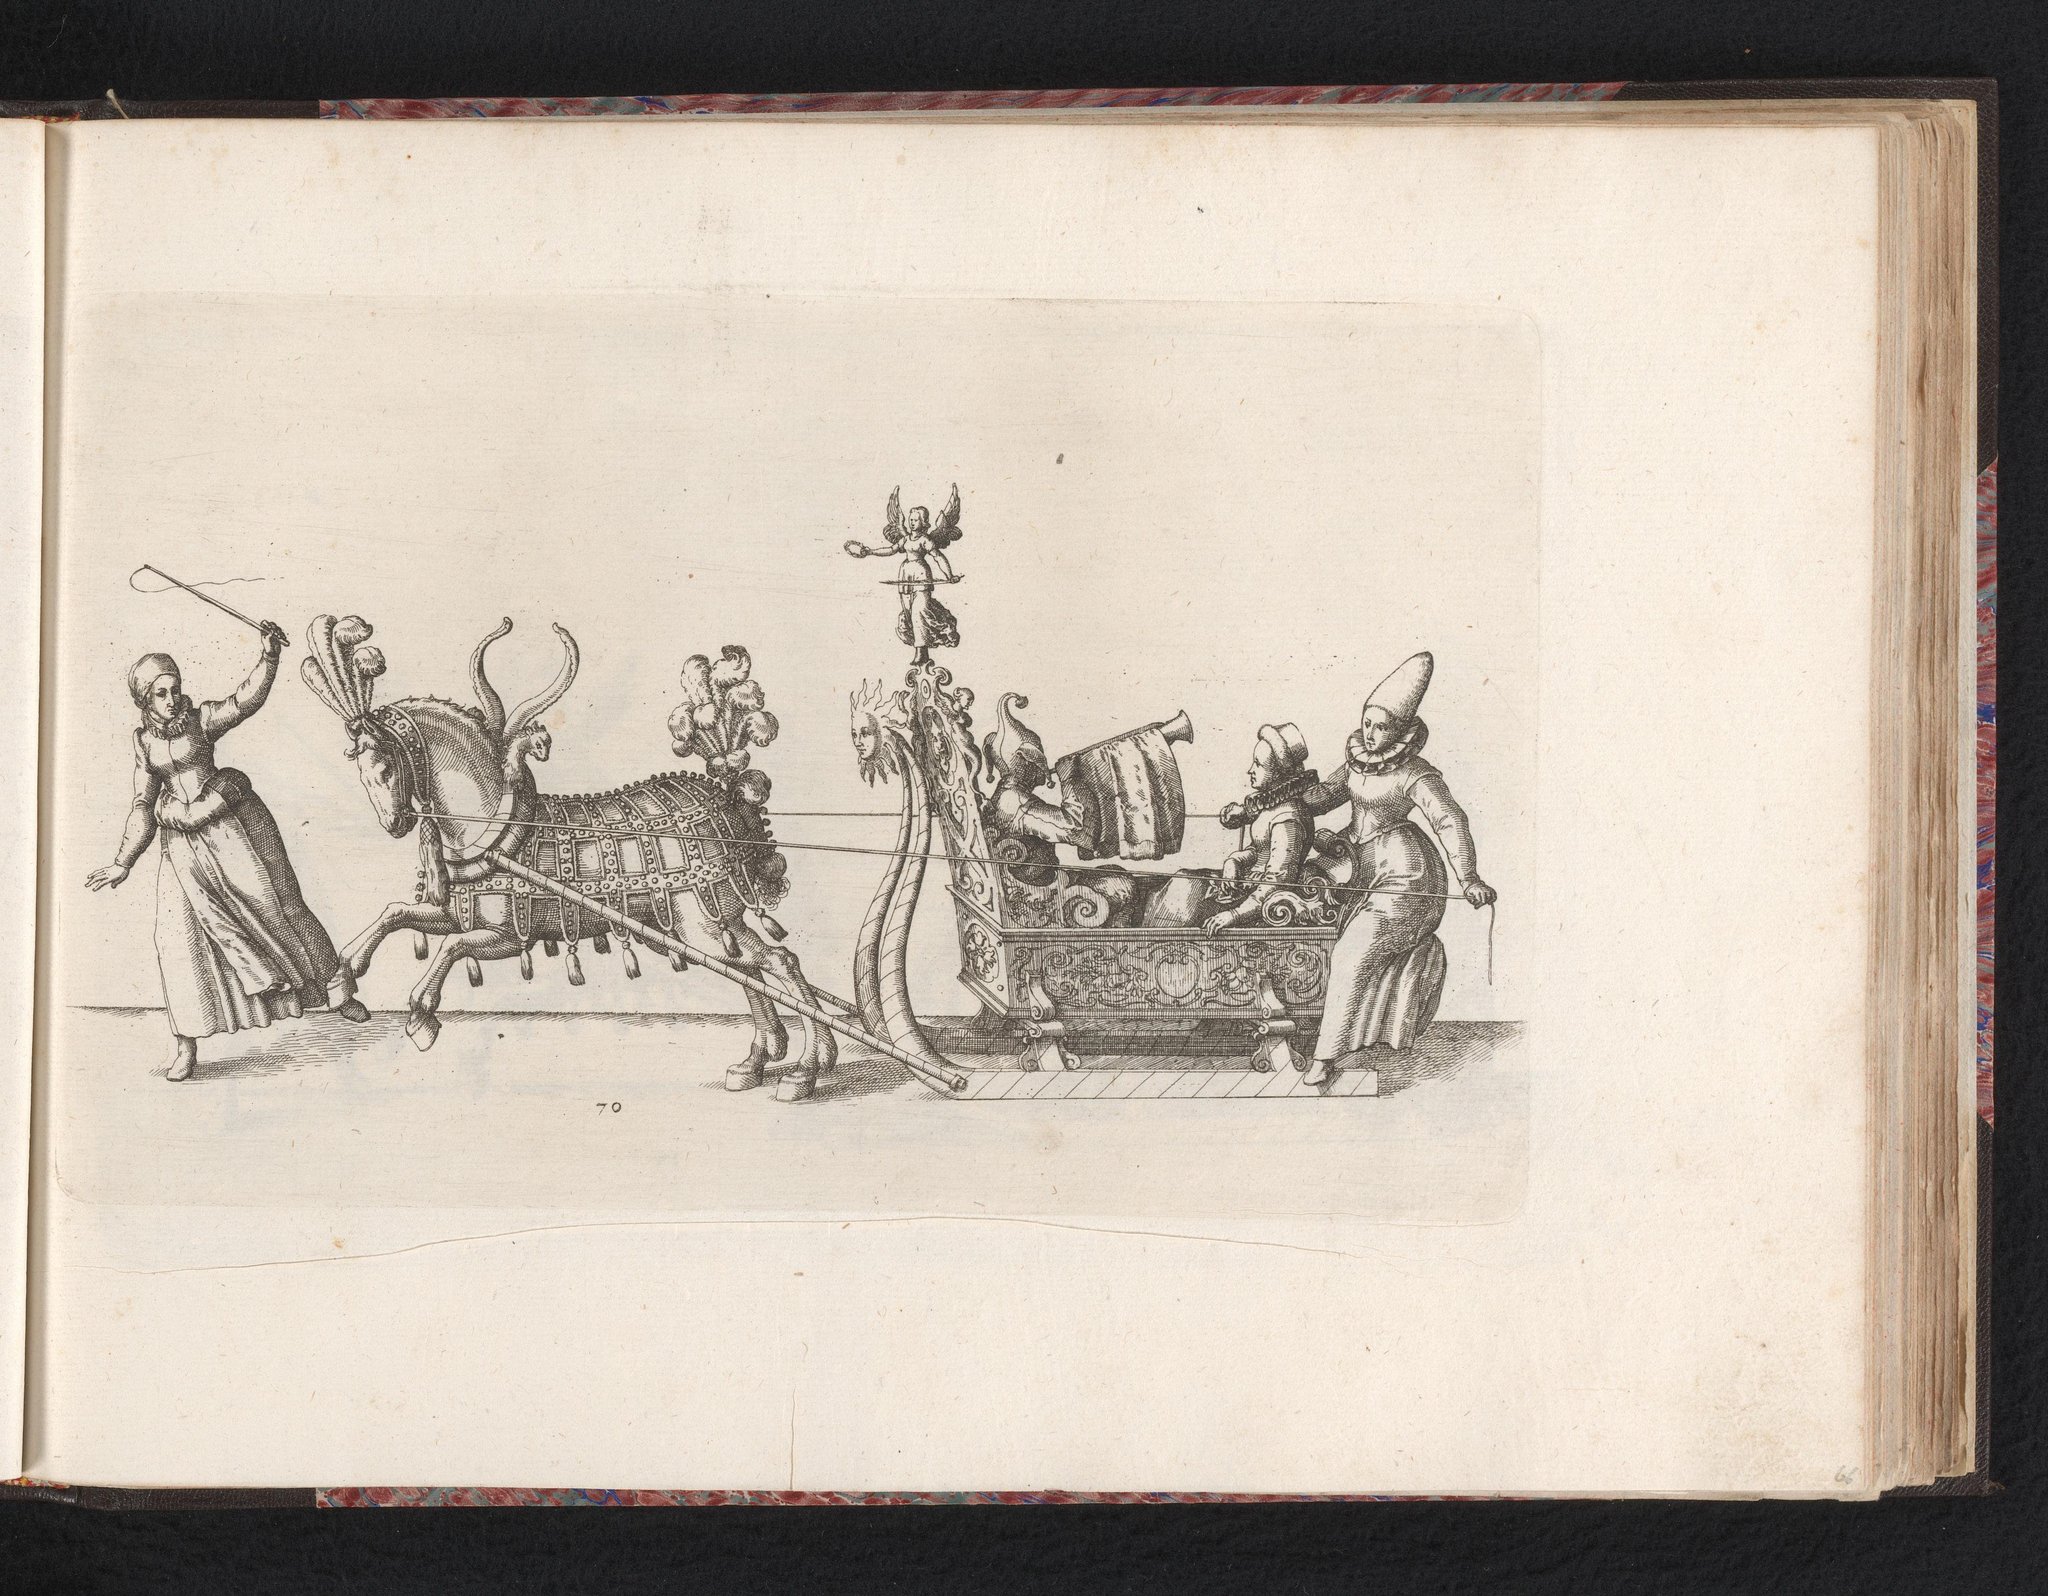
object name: album leaf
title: Optochten en ruiterspelen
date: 1618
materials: paper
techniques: etching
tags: court jester, court fool, horse-sleigh, performance in the open air (pleasure fair)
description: Genummerd: 70. Deze prent maakt deel uit van een album.